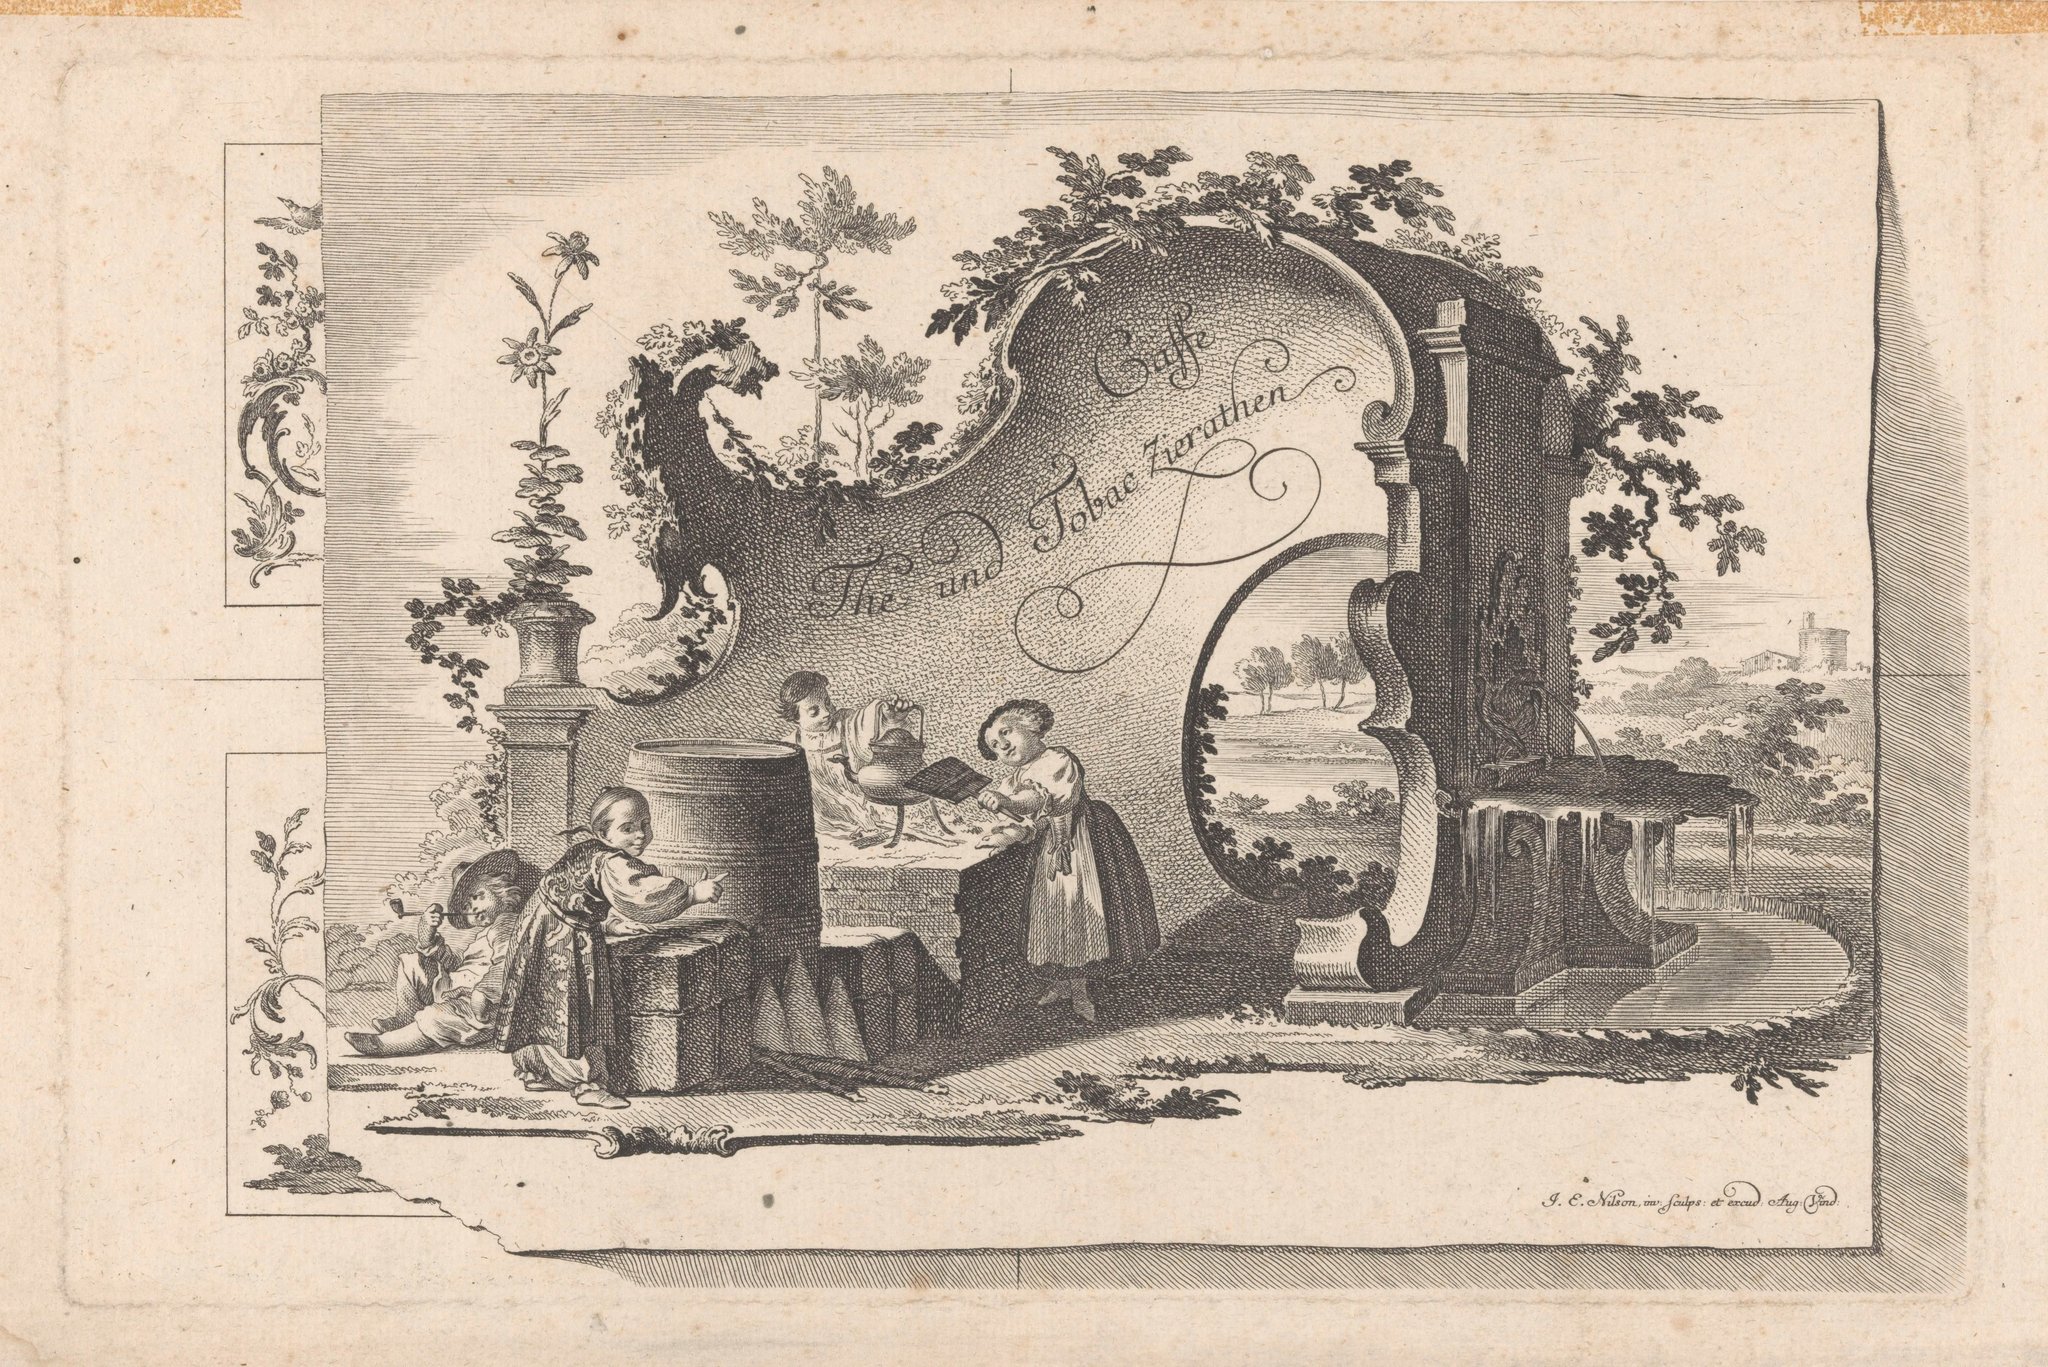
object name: titelprent, frontispice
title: Caffe The und Tobac Zierathen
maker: johann esaias nilson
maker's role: draughtsman, print maker, publisher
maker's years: 1721-1788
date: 1731-1788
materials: paper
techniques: engraving, etching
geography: augsburg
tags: coffee-pot, inn, coffee-house, public house, etc., pipe ~ tobacco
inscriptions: collector's mark: Lugt 2760, collector's mark: Lugt 2228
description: Na de overname van de firma Niemeyer door British American Tabacco Group besloot deze de collectie van het Niemeyer Tabaksmuseum af te stoten. De beheerder van de collectie, het Noordelijk Scheepvaartmuseum, organiseerde in januari 2011 open dagen voor musea waar deze hun voorkeuren voor collectieonderdelen kenbaar konden maken. De objecten zijn getaxeerd door medewerkers van Christie's en vervolgens ter overname aangeboden aan de belangstellende musea. Het Rijksprentenkabinet koos 46 prenten uit de collectie tegen door de medewerkers van Christie's vastgestelde waarde. [H. Leeflang, 2011-06-09]